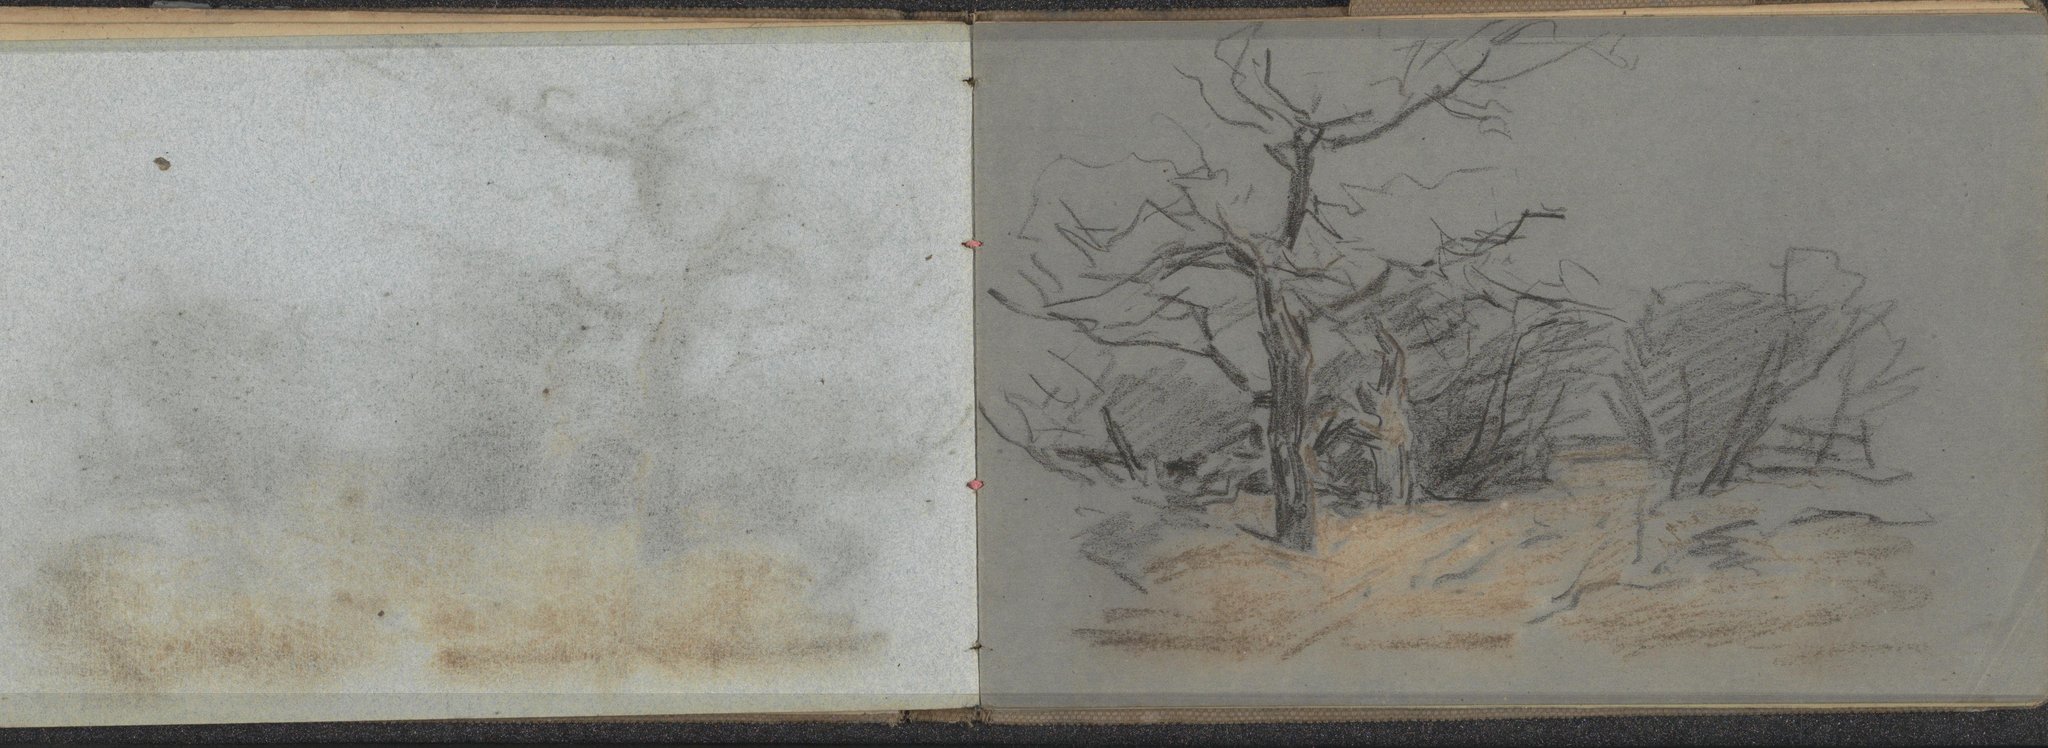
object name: sketchbook leaf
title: Landschap met bomen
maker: louis apol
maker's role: draughtsman, painter, print maker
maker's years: 1850-1936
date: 1809-1880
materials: chalk, paper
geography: norway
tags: trees, landscapes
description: Blad 20 recto uit een schetsboek met 38 bladen betekend tijdens de expeditie naar Nova Zembla in 1880.